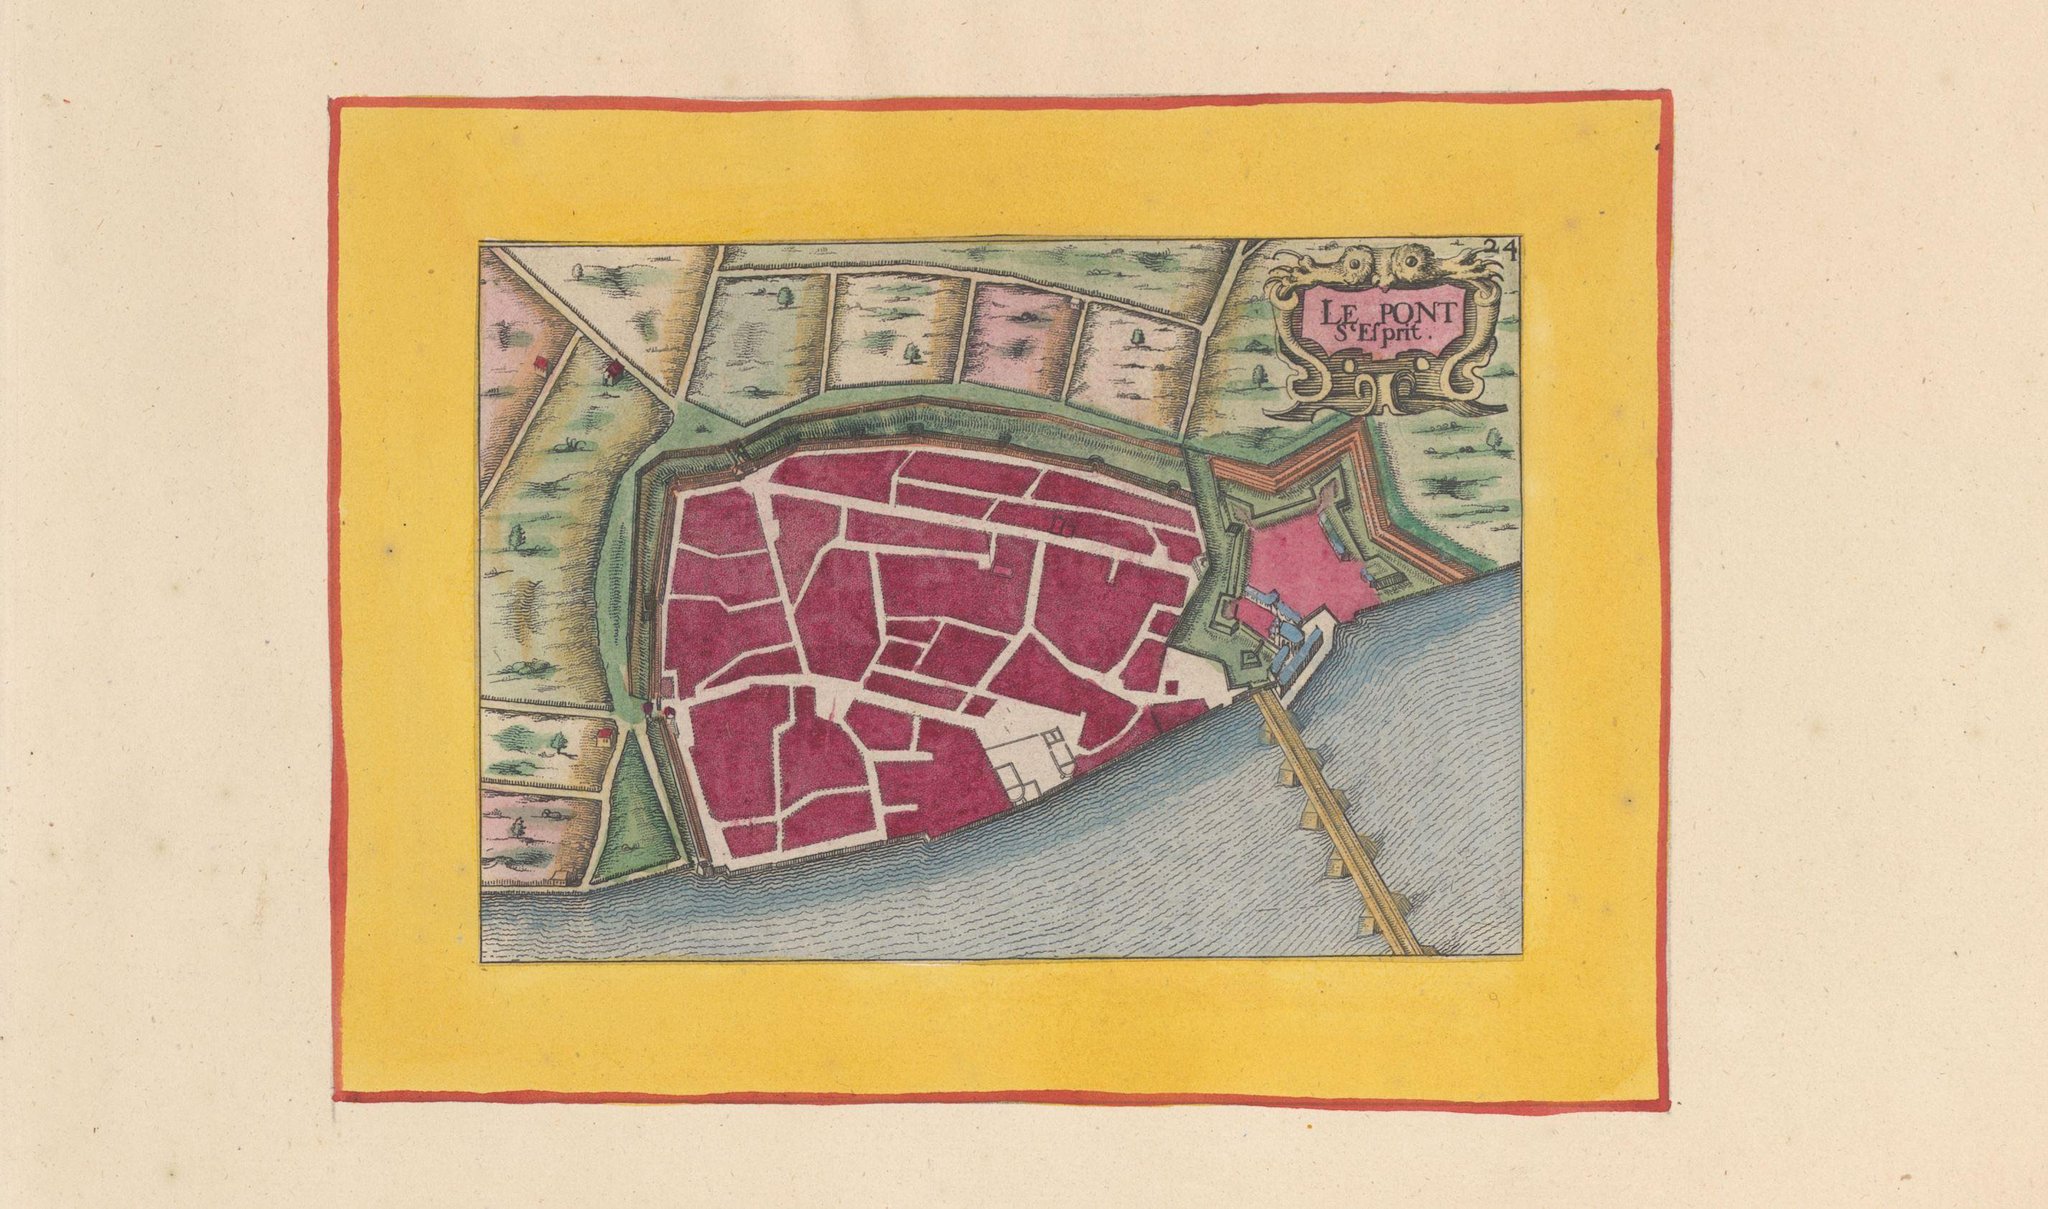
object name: area plan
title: Le Pont St. Esprit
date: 1638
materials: paper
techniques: engraving, etching, hand coloring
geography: the hague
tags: maps of cities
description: Prent uit: Tassin, Christophe. Les plans et profils de toutes les principales villes et lieux considérables de France (...). Parijs: Michel van Lochom, 1638, prent nummer 24 in het deel 'Languedoc'.